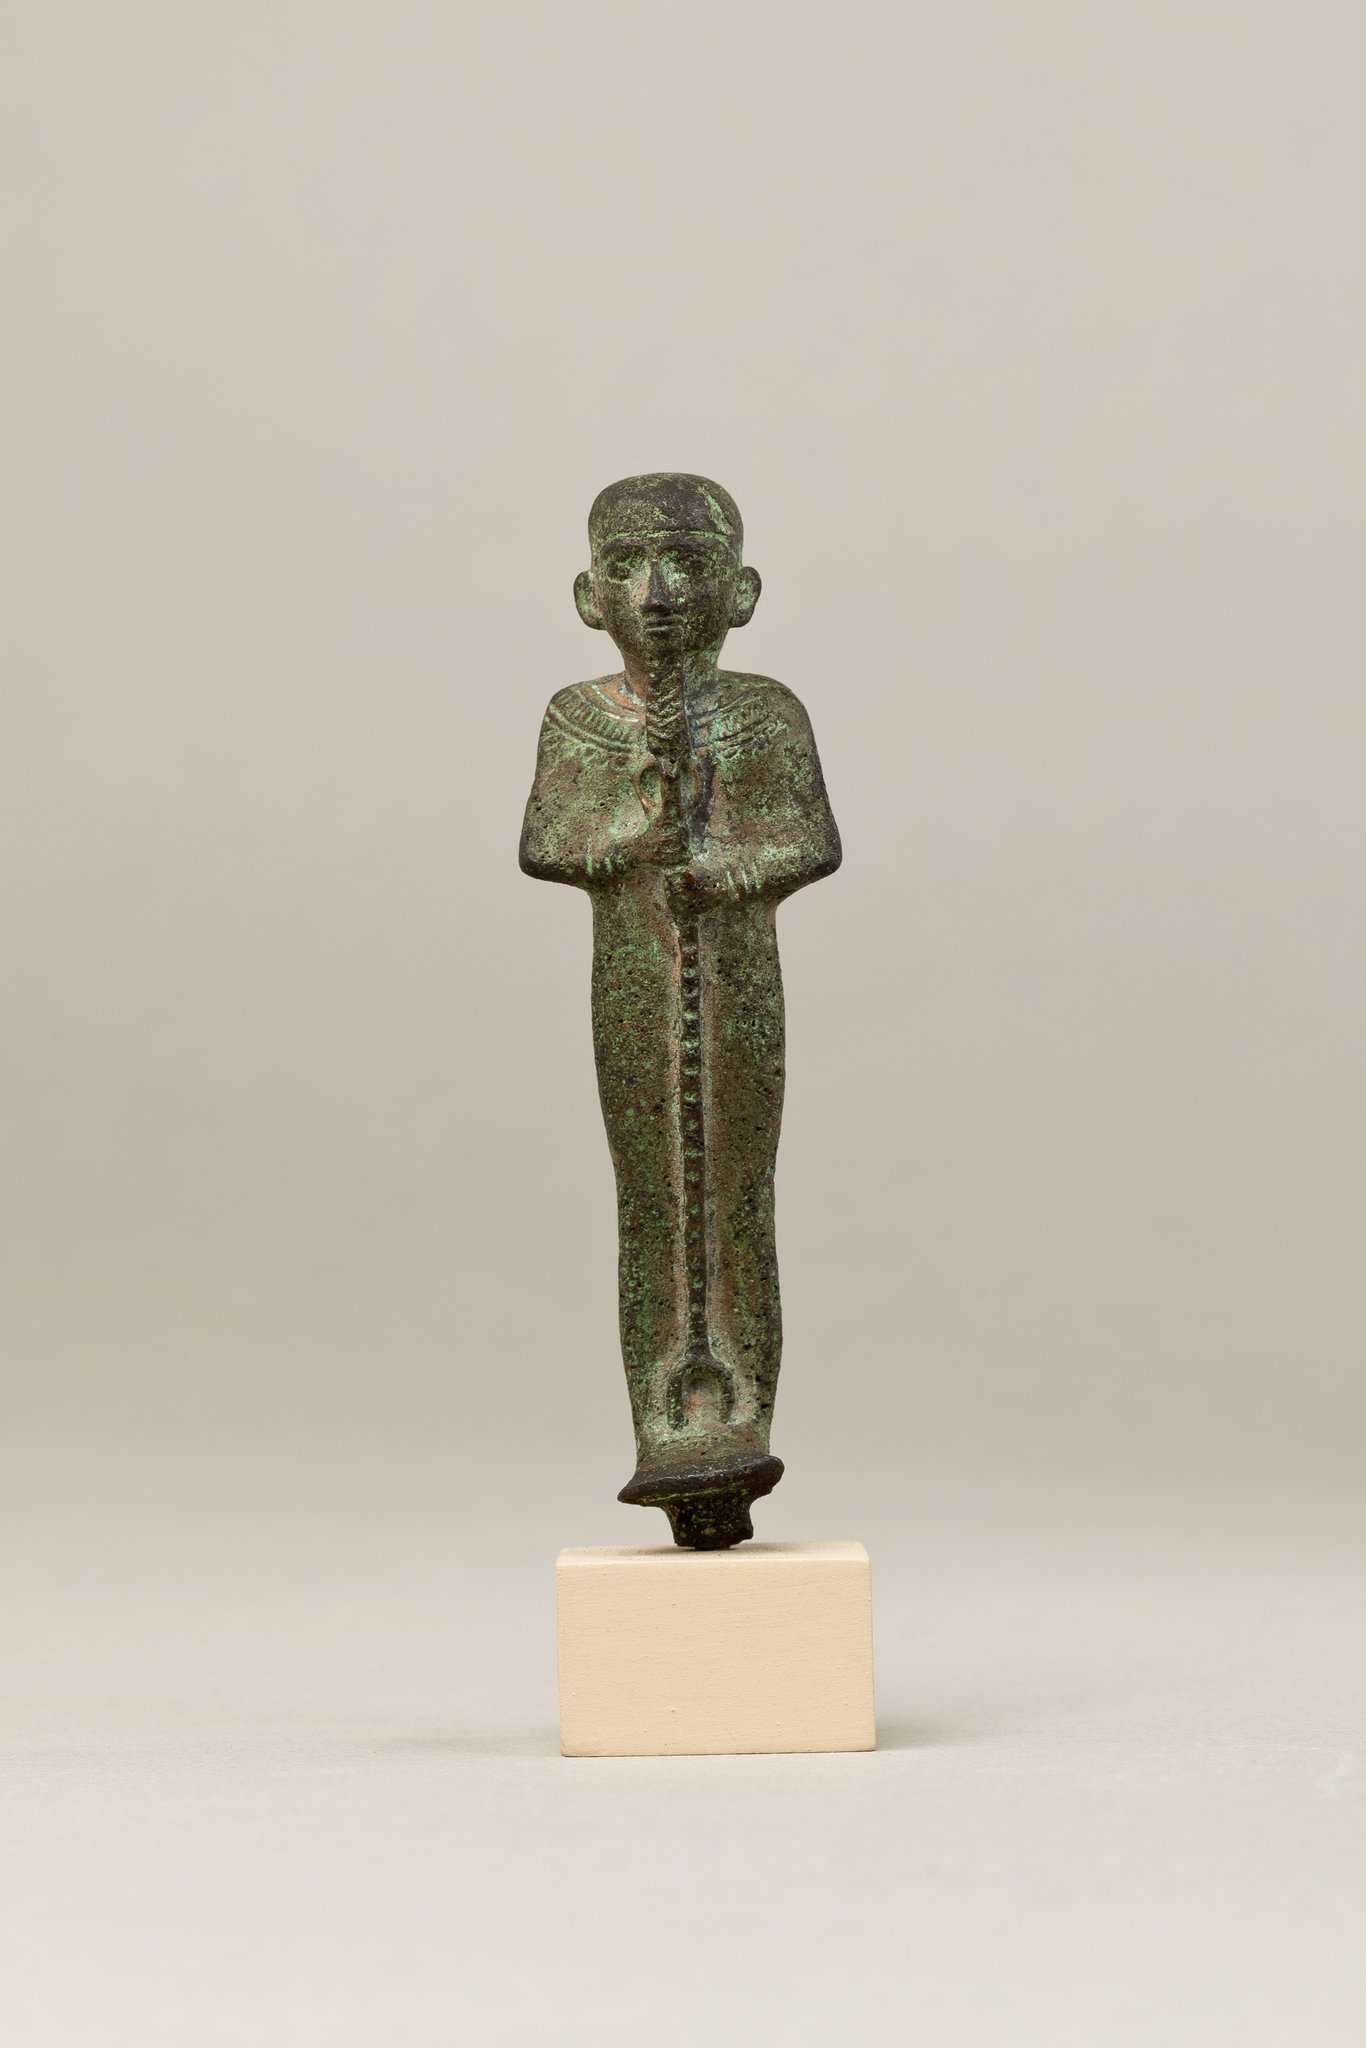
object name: statuette, ptah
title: Ptah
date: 664-630 BCE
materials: metal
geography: egypt